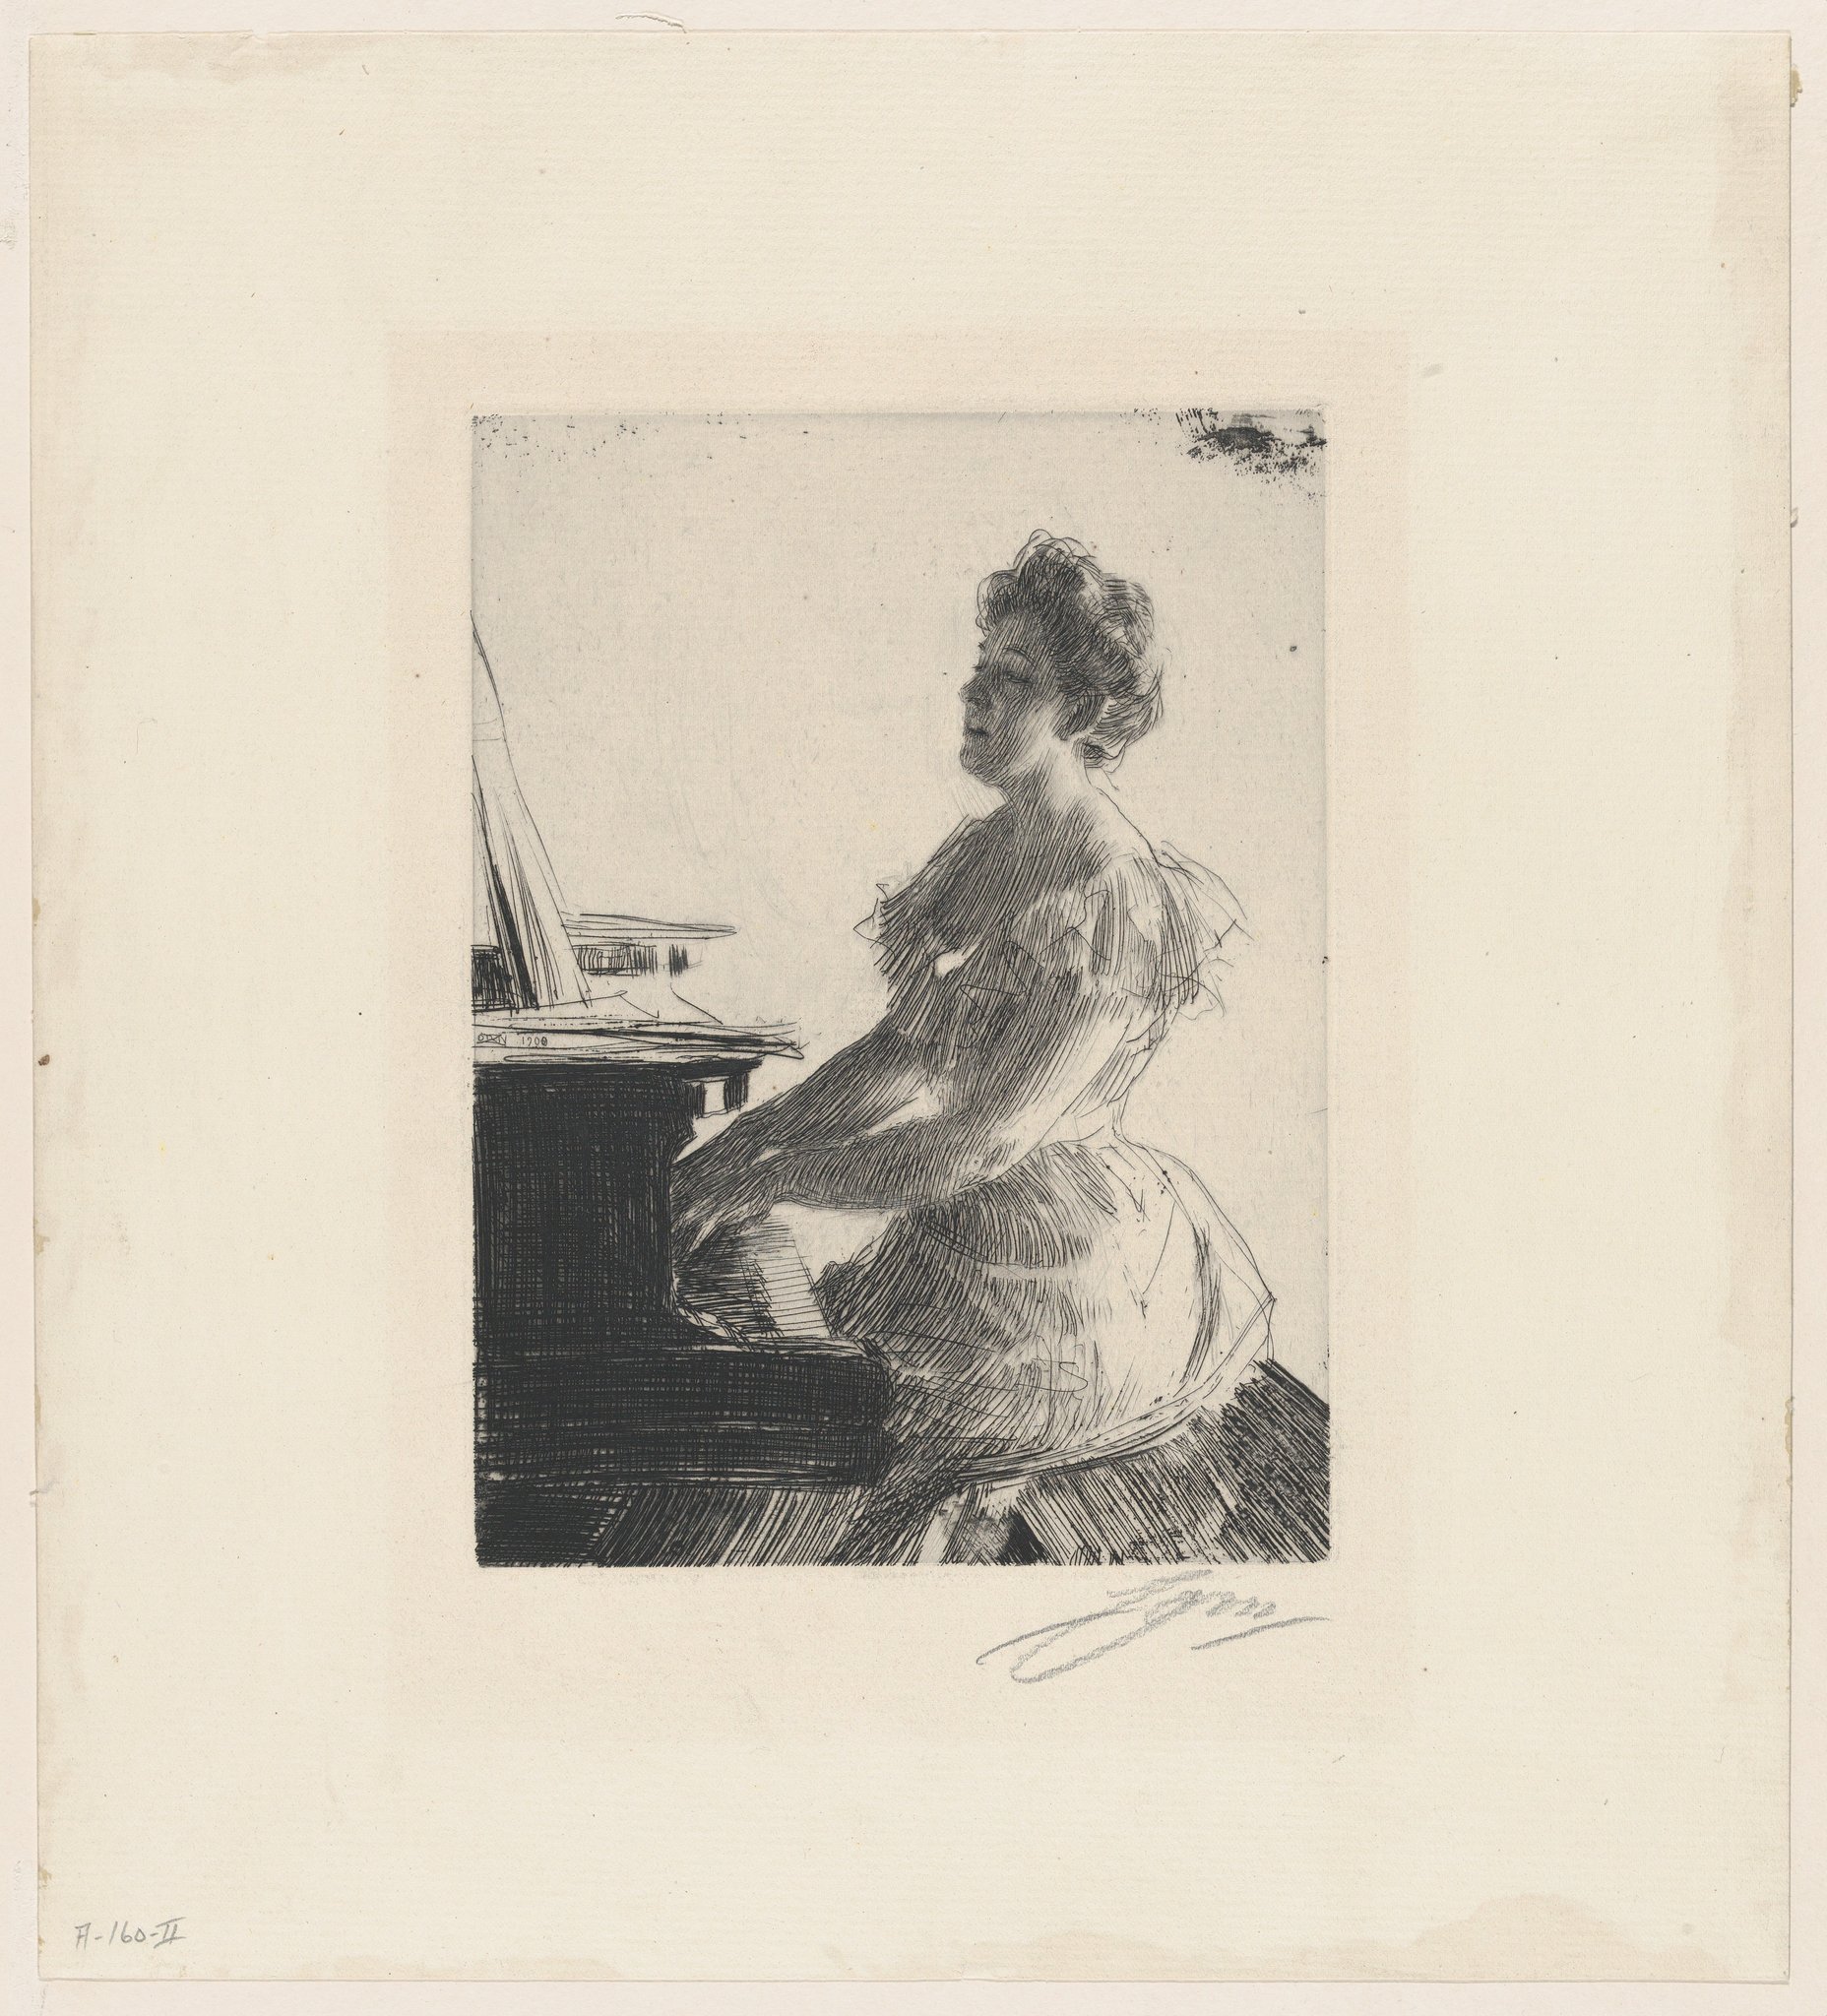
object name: print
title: At the Piano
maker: anders zorn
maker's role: artist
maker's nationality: swedish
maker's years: 1860-1920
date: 1900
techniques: etching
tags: women,pianos